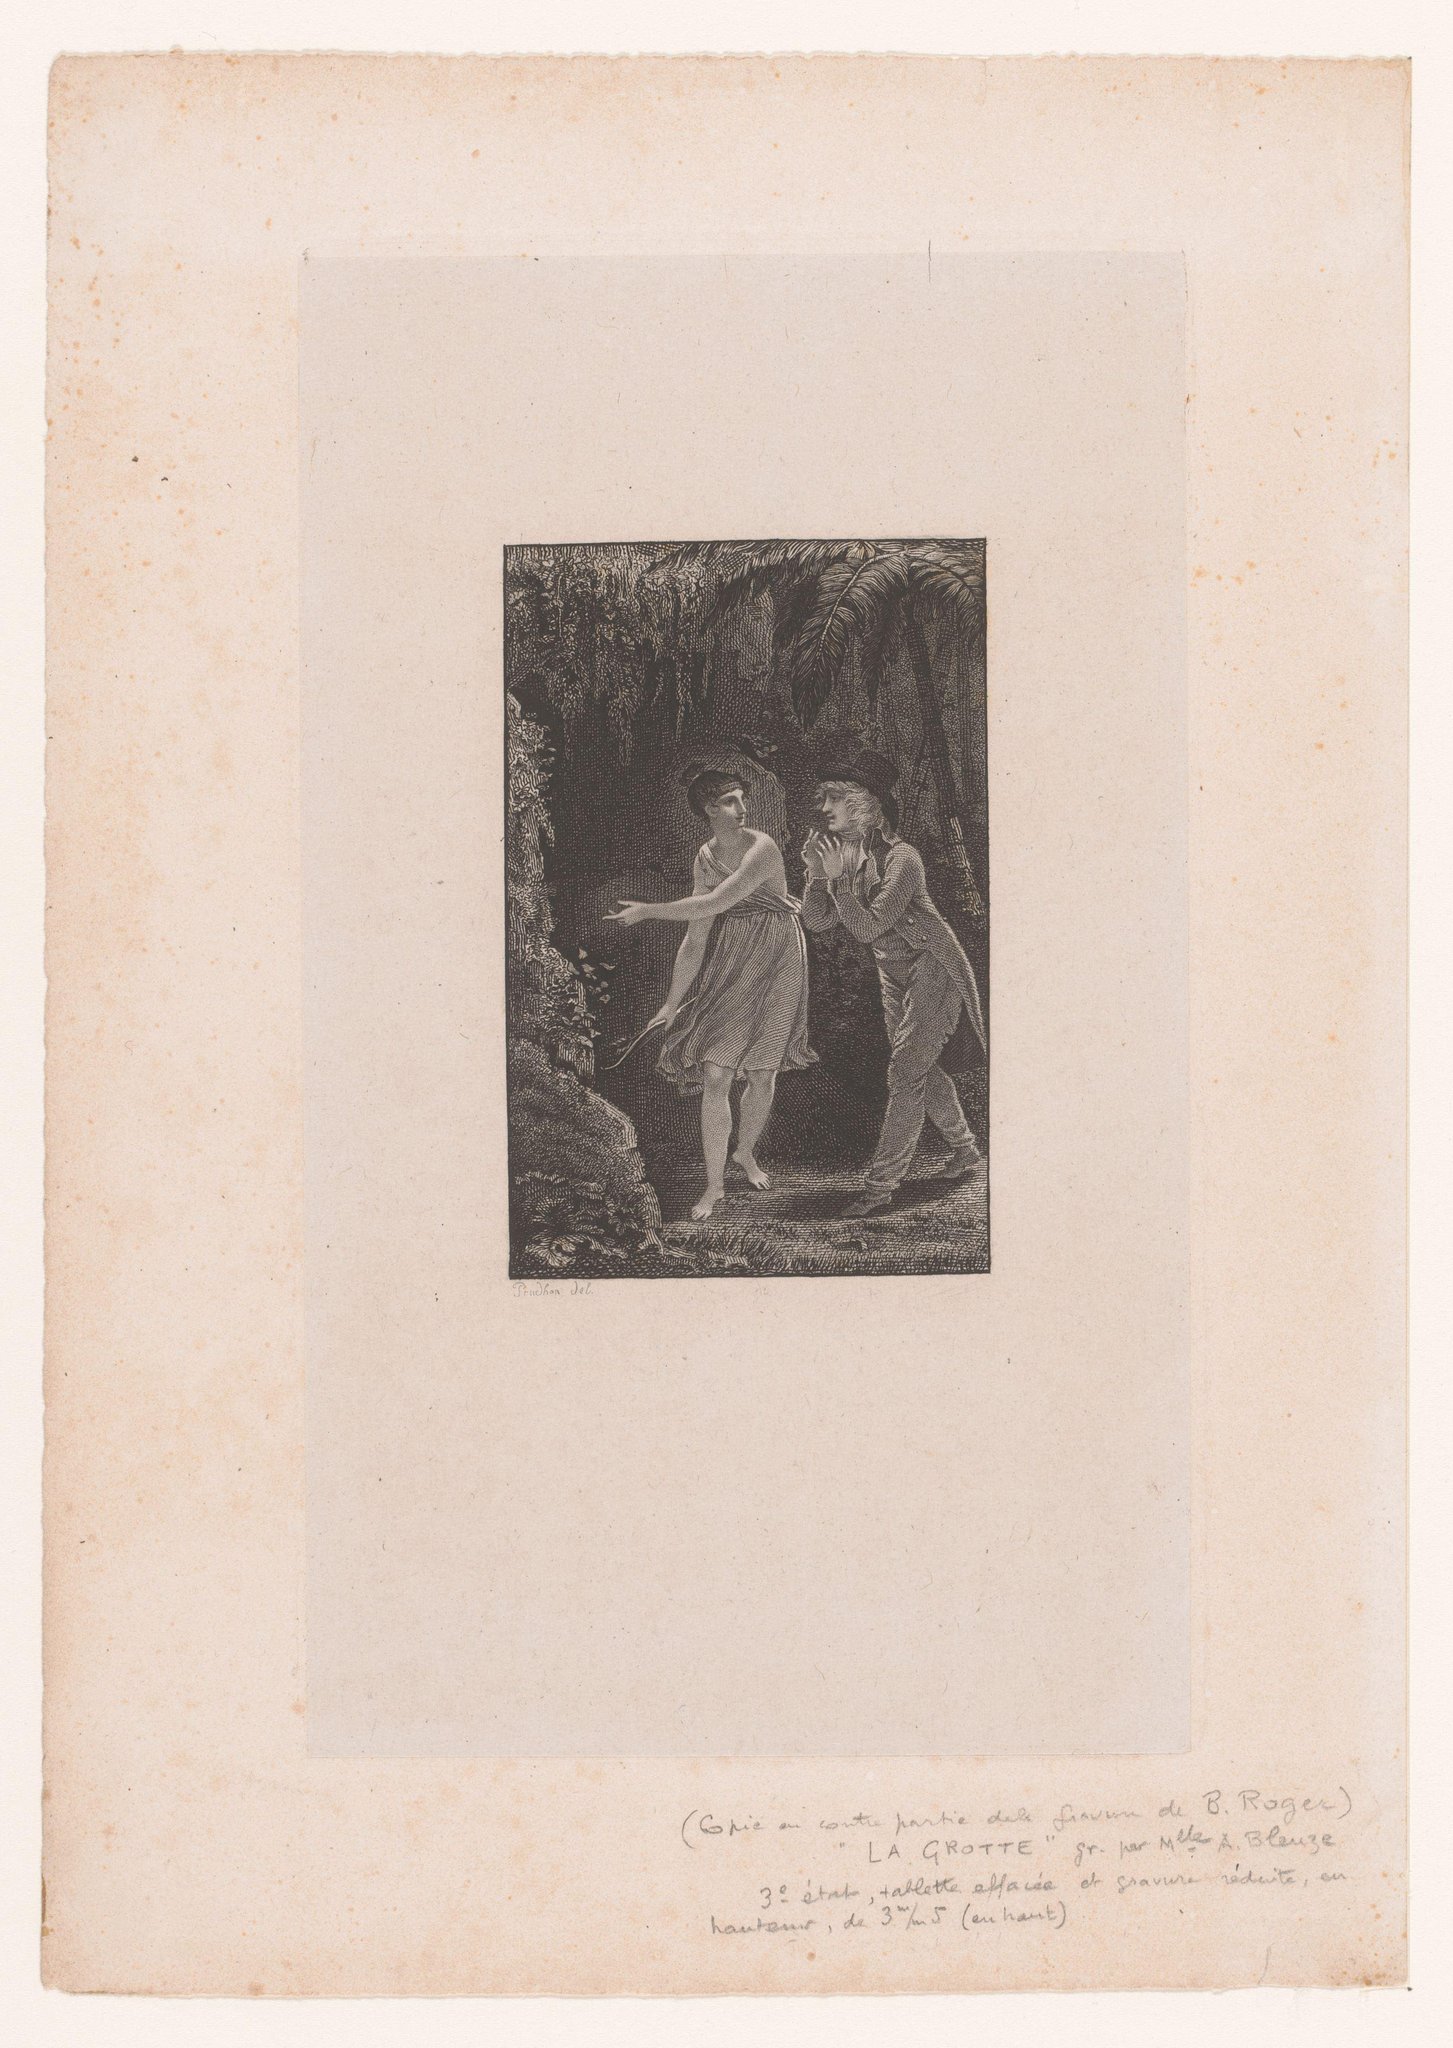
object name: print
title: La Grotte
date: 1799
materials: paper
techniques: engraving, etching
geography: paris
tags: literary characters and objects, cave, grotto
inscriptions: collector's mark: Lugt 2228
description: Prent uit: Bonaparte, Lucien. La Tribu Indienne. Parijs: Honnert, 1799.